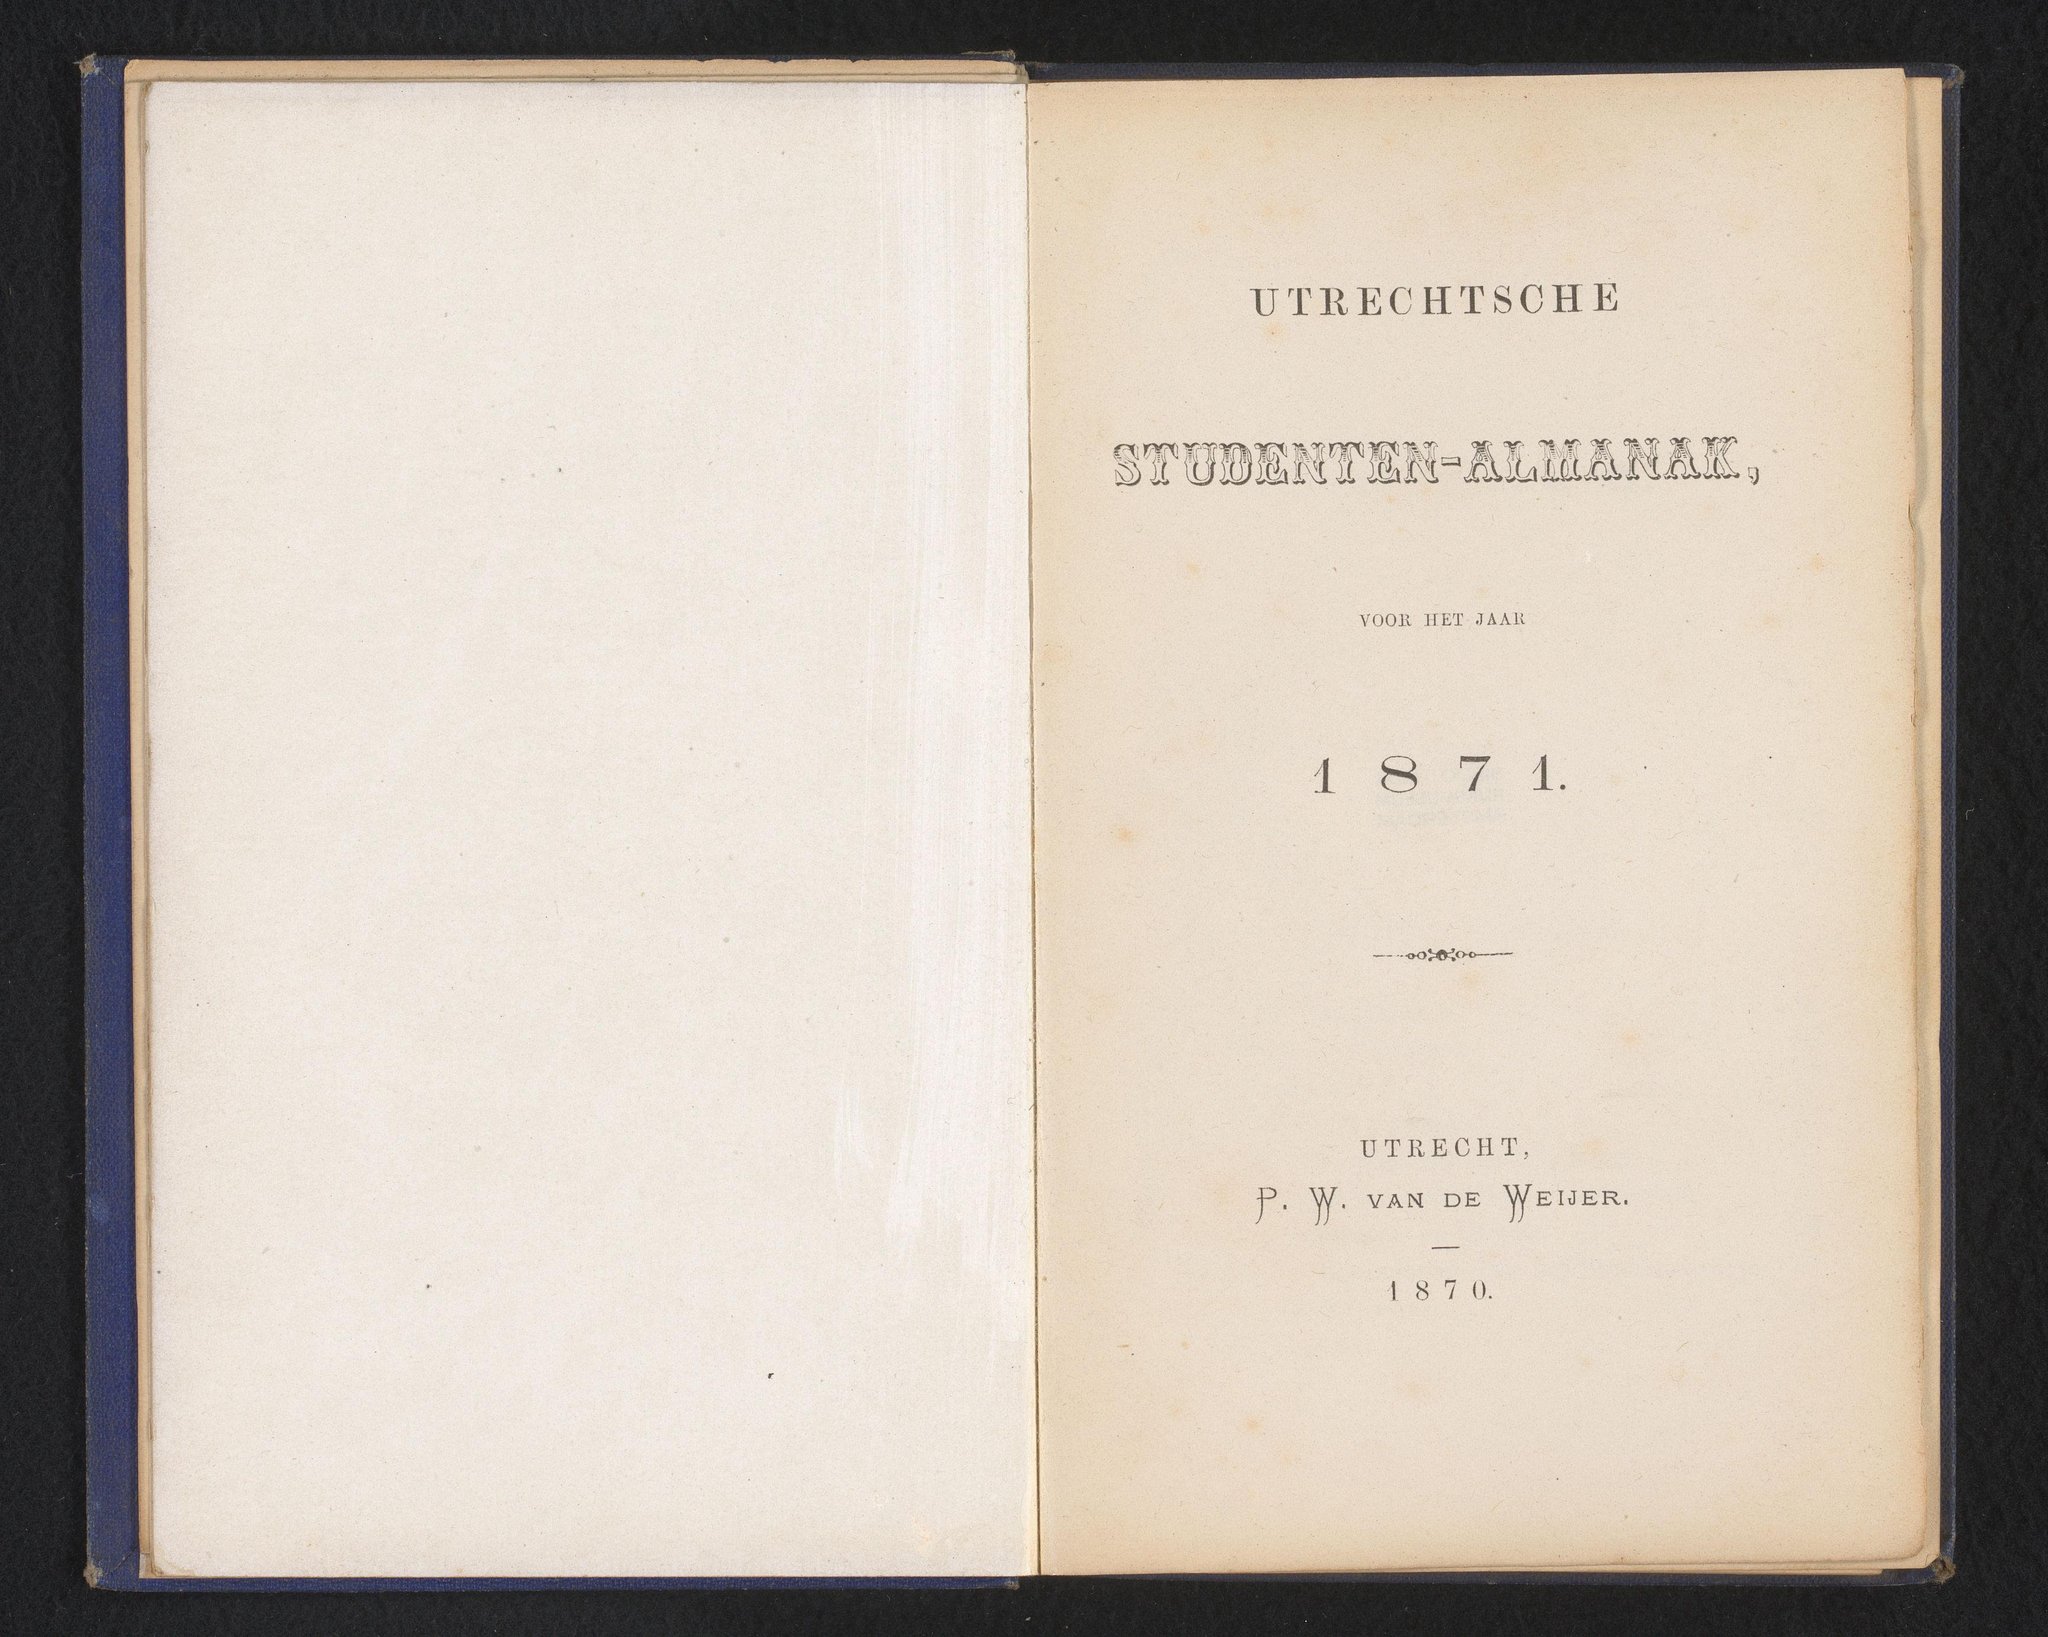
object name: book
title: Utrechtsche studenten-almanak voor het jaar 1871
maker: pieter wilhelmus van de weijer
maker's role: print maker, printer, publisher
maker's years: 1816-1880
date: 1870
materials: paper, cardboard, leather, linen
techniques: letterpress printing, lithograph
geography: utrecht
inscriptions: number: ‘2.80’, retailer's mark: ‘Boekhandel/ van/ J. Greven/ Ganzenmarkt/ Utrecht.’